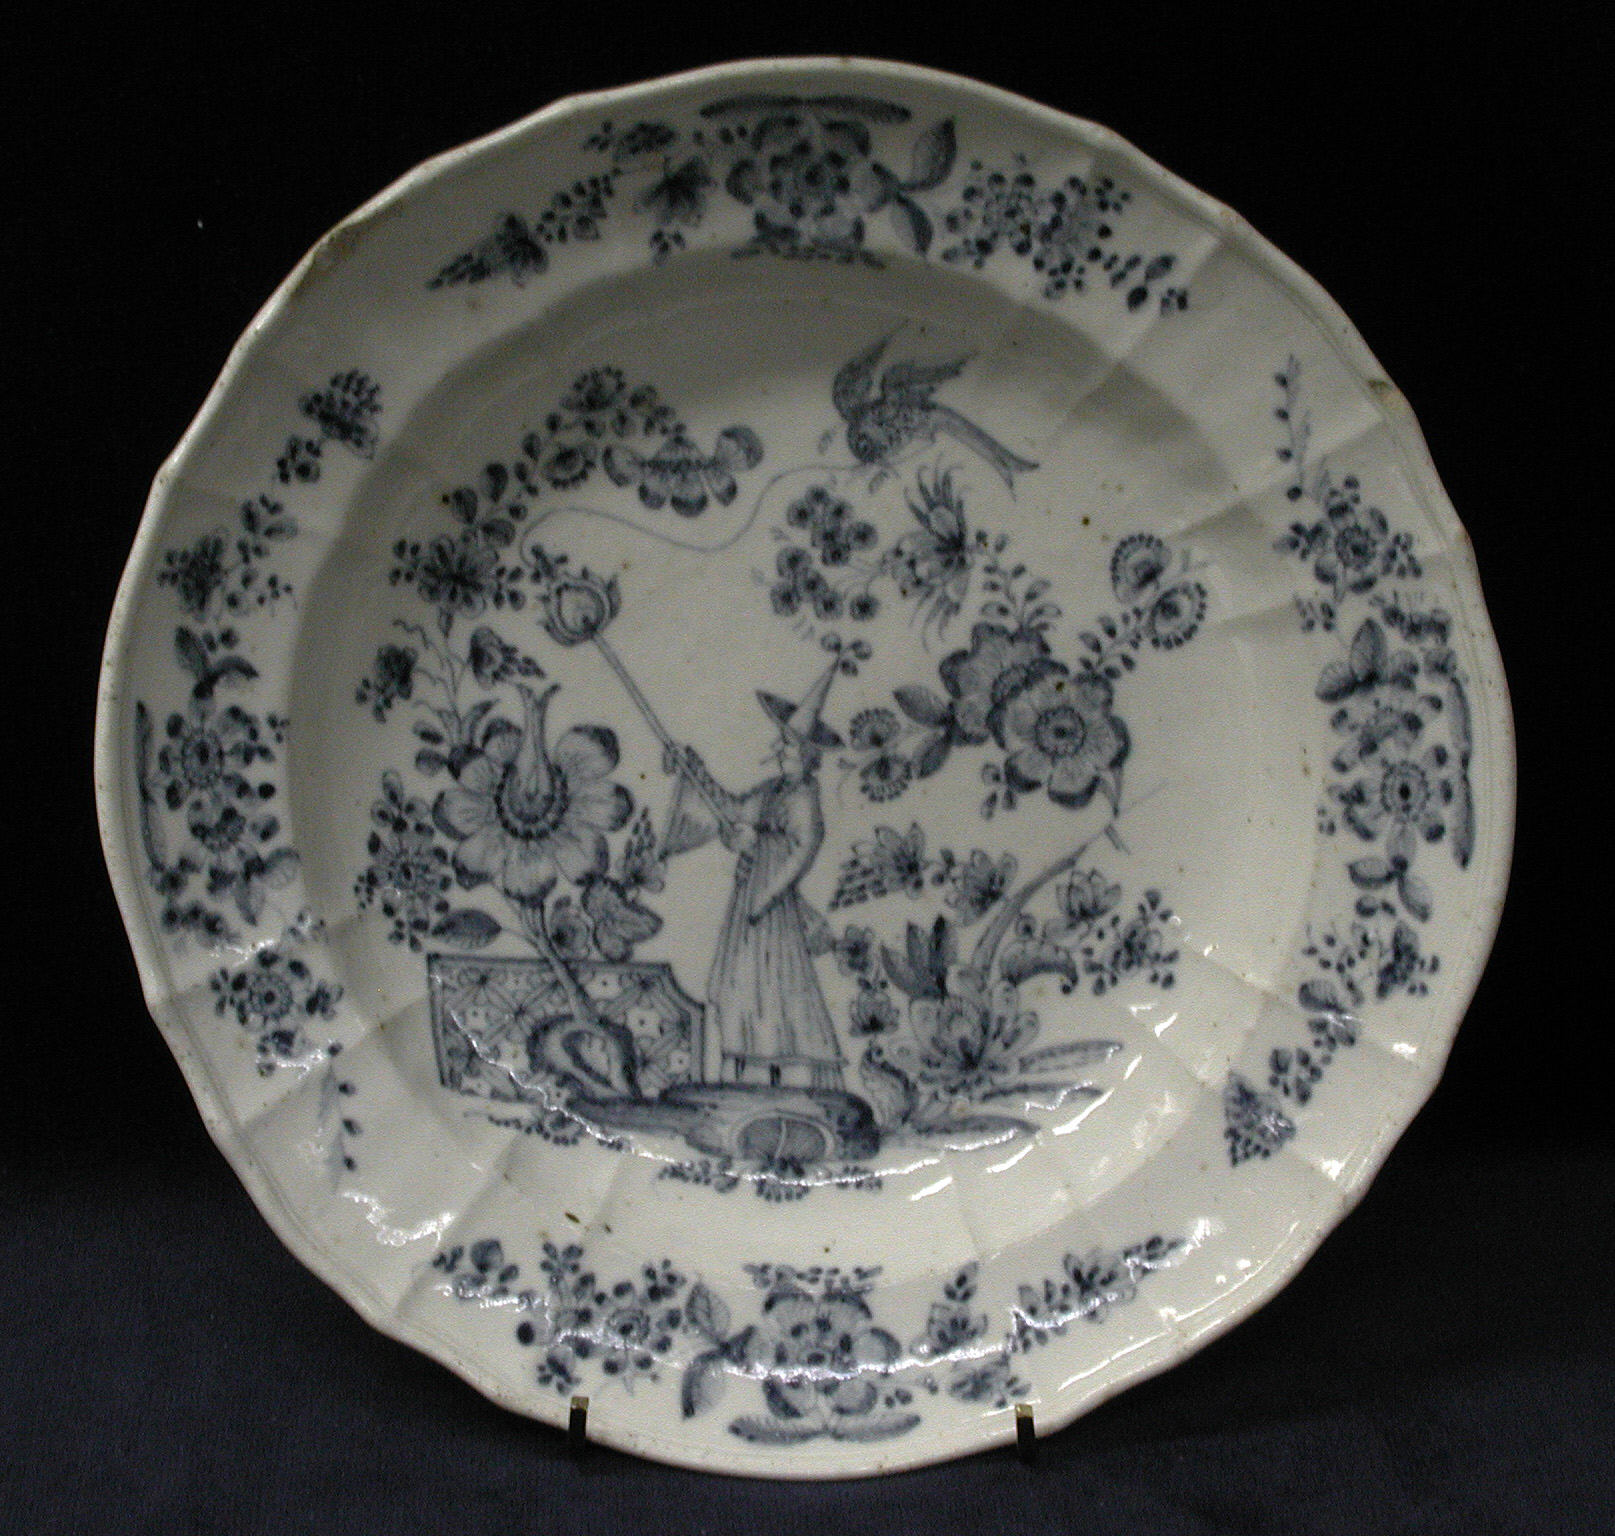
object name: soup plate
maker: wallendorf porcelain manufactory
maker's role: manufactory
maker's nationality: german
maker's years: 1764-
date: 1765-1775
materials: hard paste porcelain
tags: birds,men,flowers